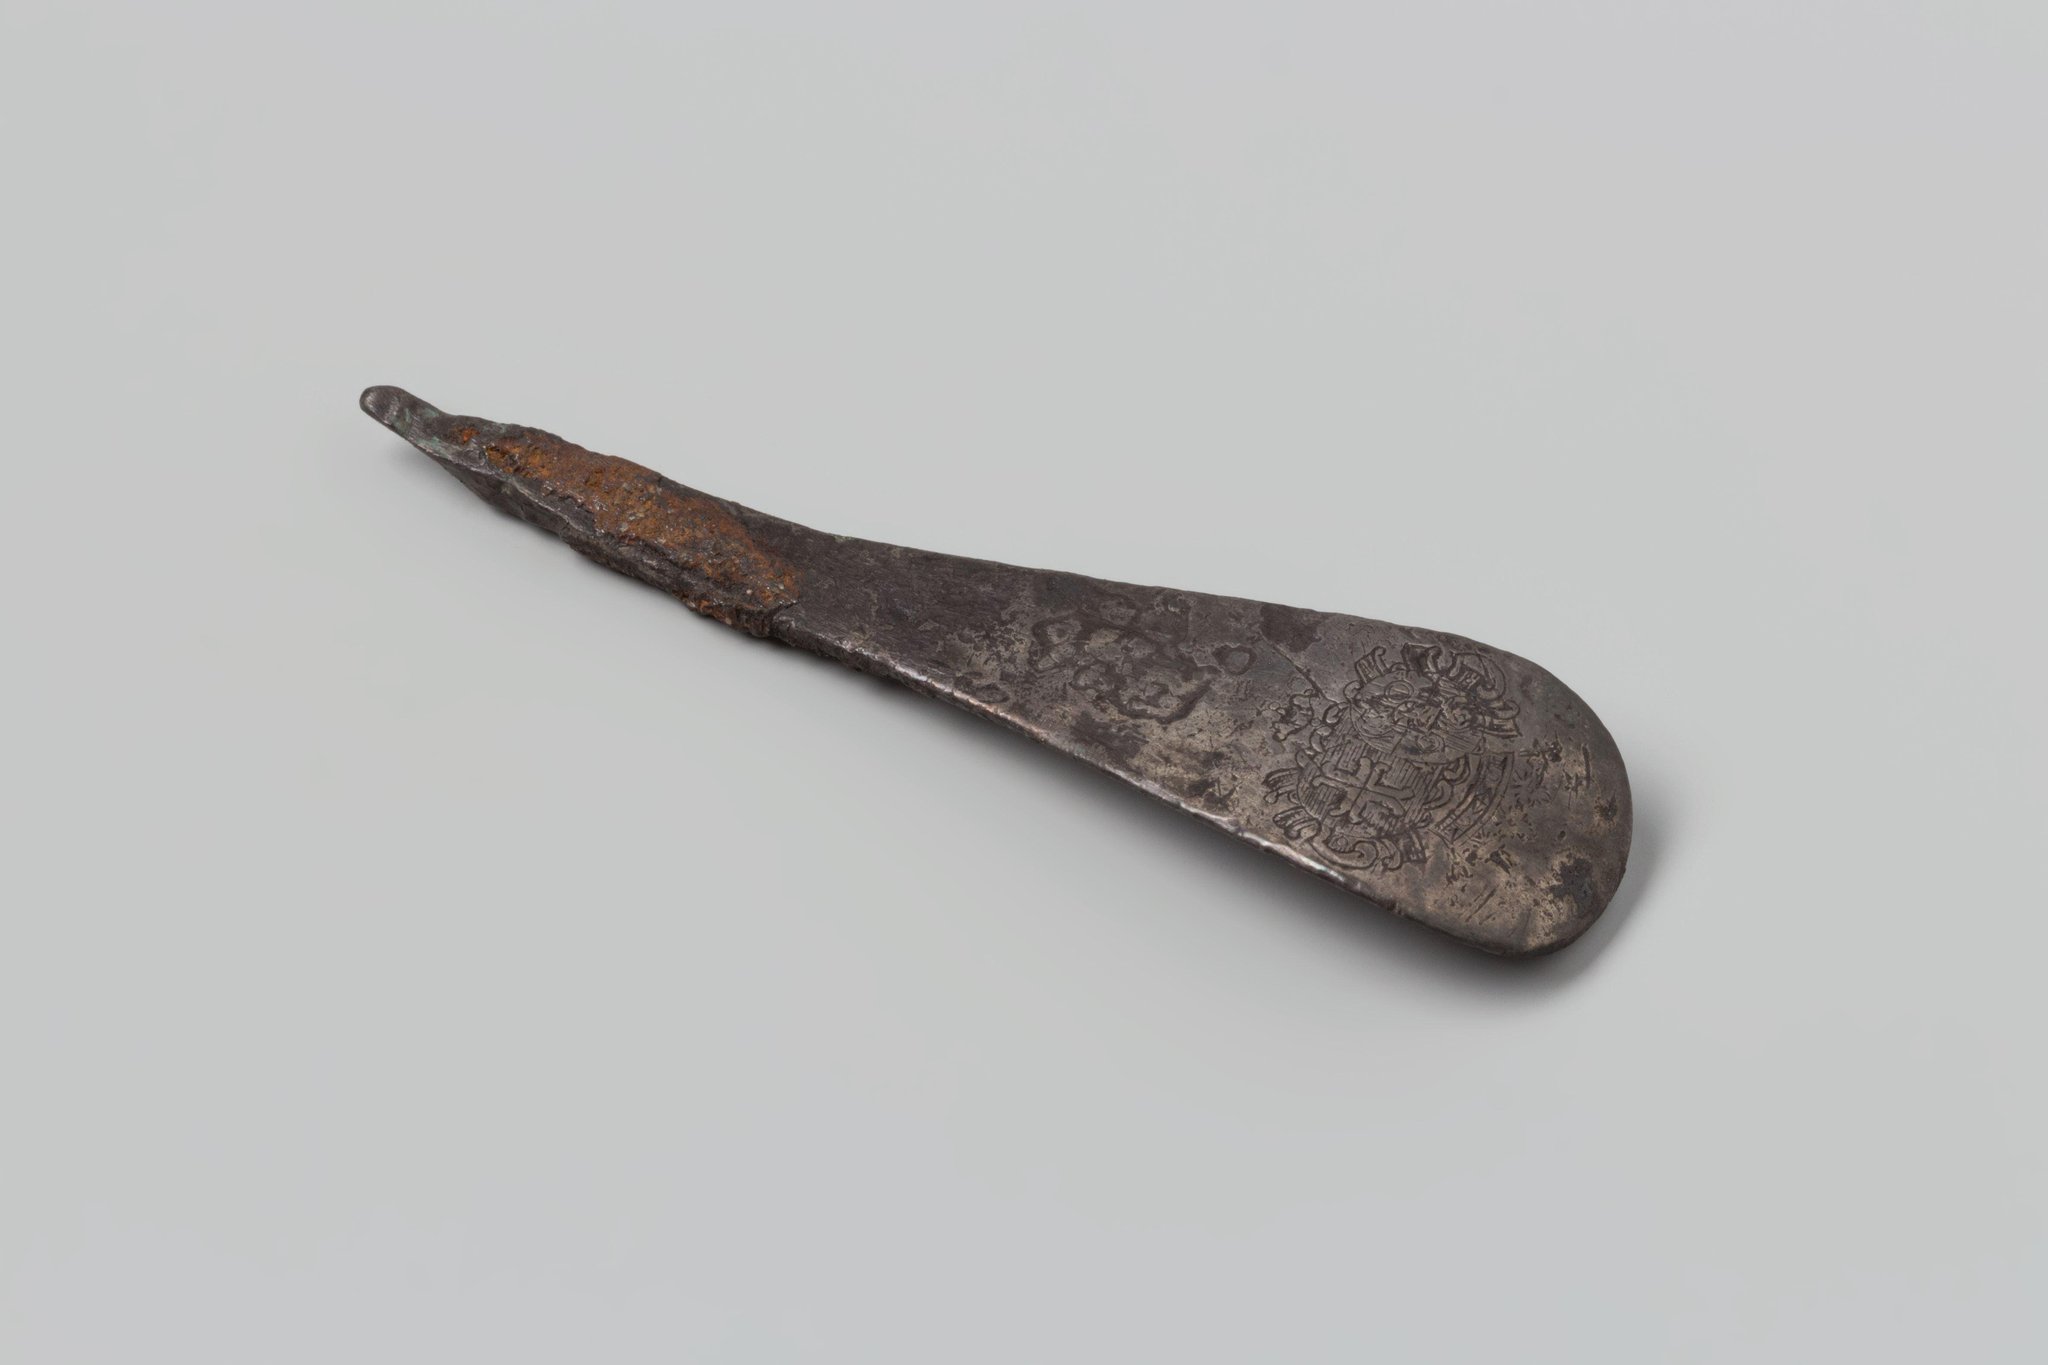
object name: spoon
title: Steel van vork of lepel uit het wrak van de Oost-Indiëvaarder Hollandia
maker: Anonymous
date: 1700-1743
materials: silver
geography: netherlands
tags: verenigde oostindische compagnie, hollandia (schip), annet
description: Cutlery, fragment: stem of fork or spoon; fragm, end, sim. NG 1980-27H2909/2608, with traces of coat of arms [of van Imhoff-Bentinck].